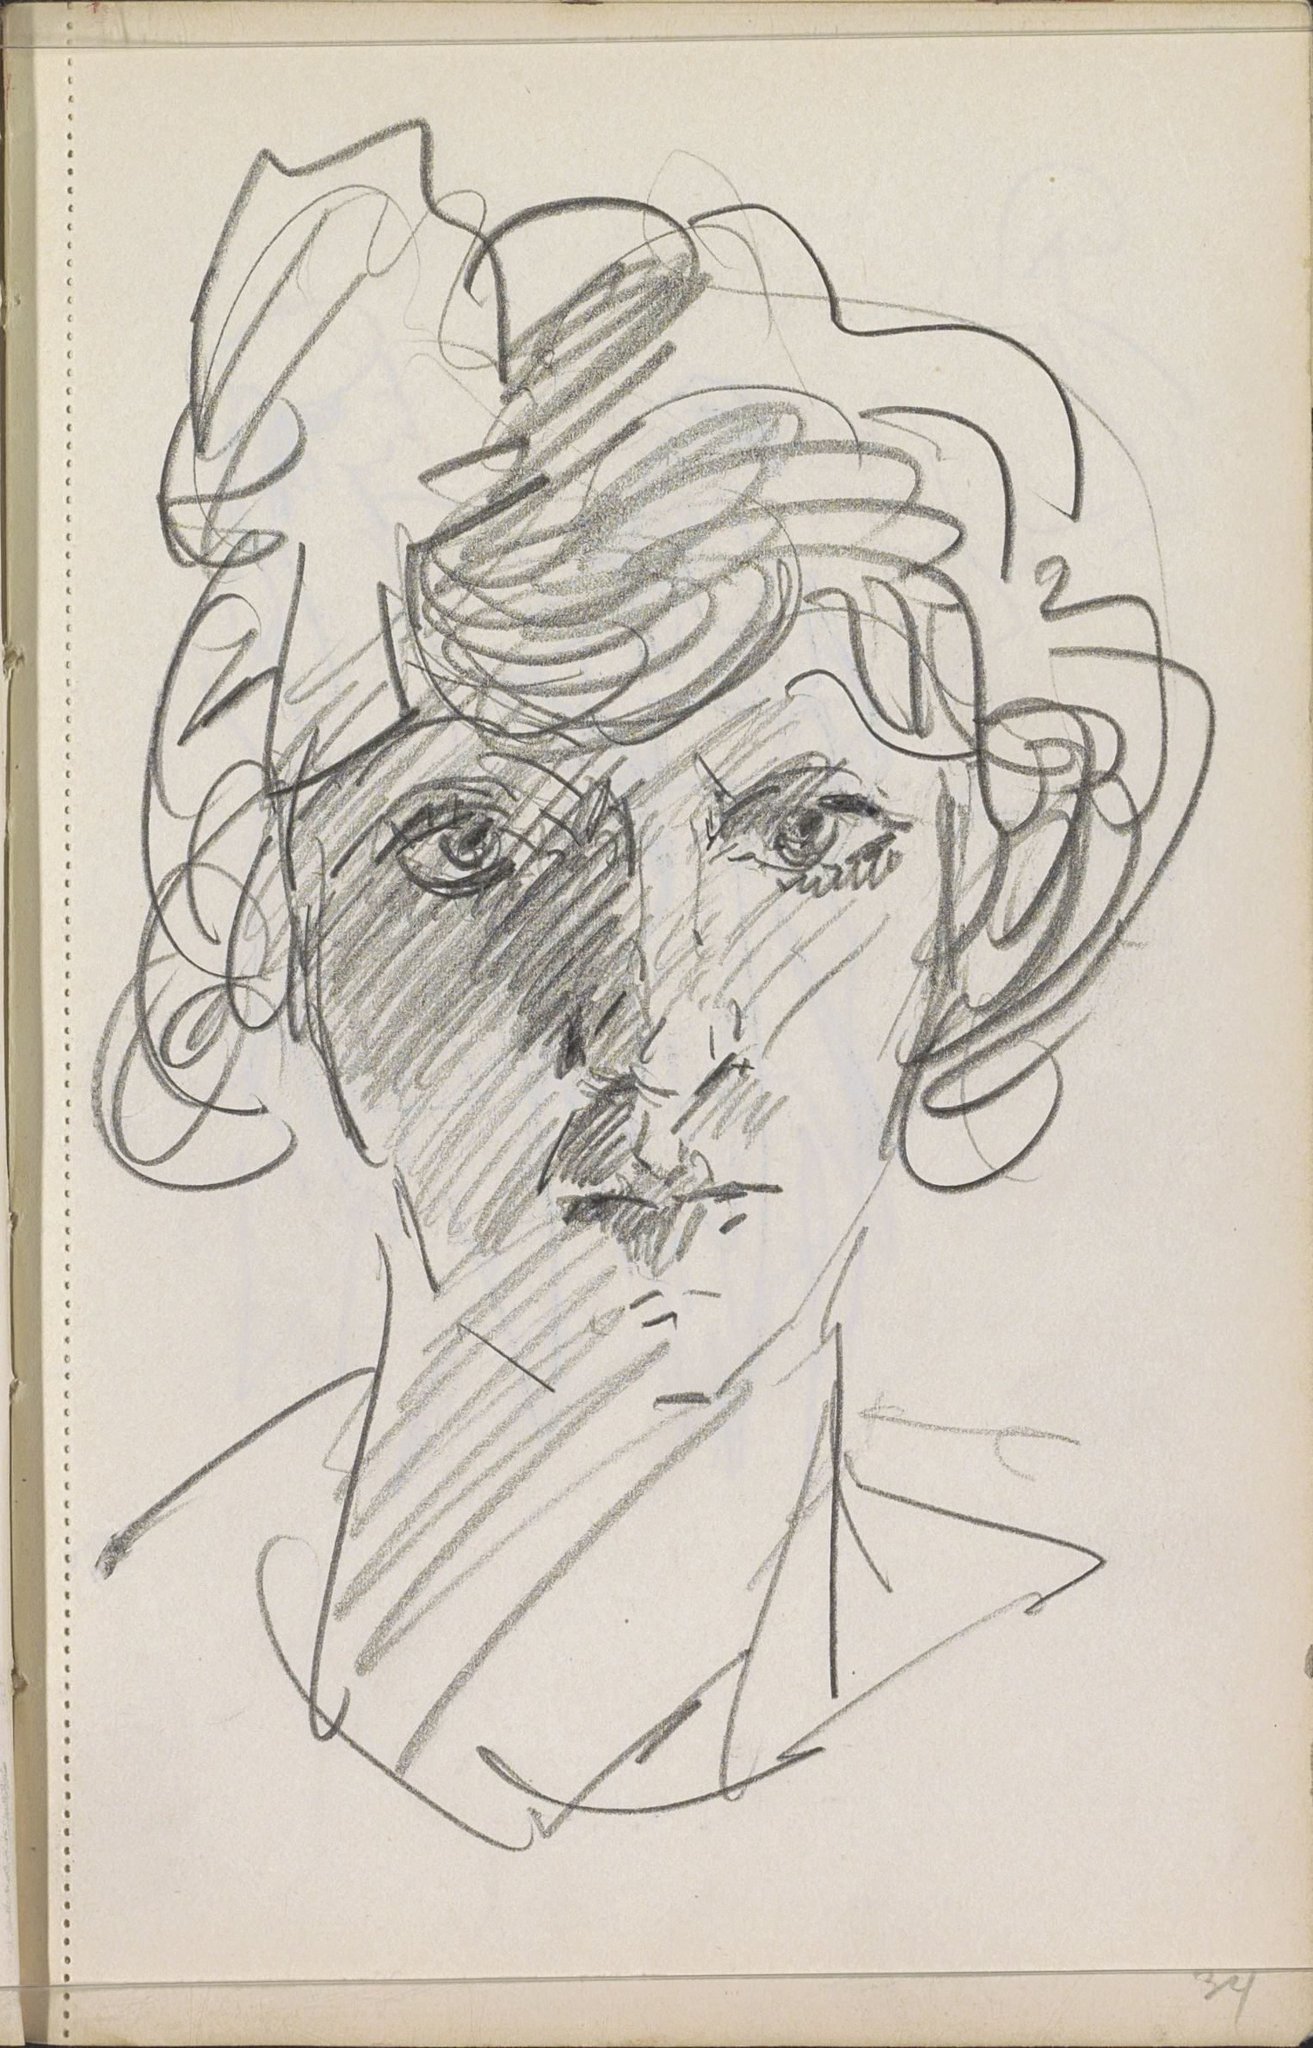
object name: sketchbook leaf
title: Vrouwenhoofd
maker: isaac israels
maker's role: draughtsman, painter, print maker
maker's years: 1865-1934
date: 1875-1934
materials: paper, pencil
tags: head (human) - aa - female human figure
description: Blad 34 recto uit schetsboek LII met 43 bladen.